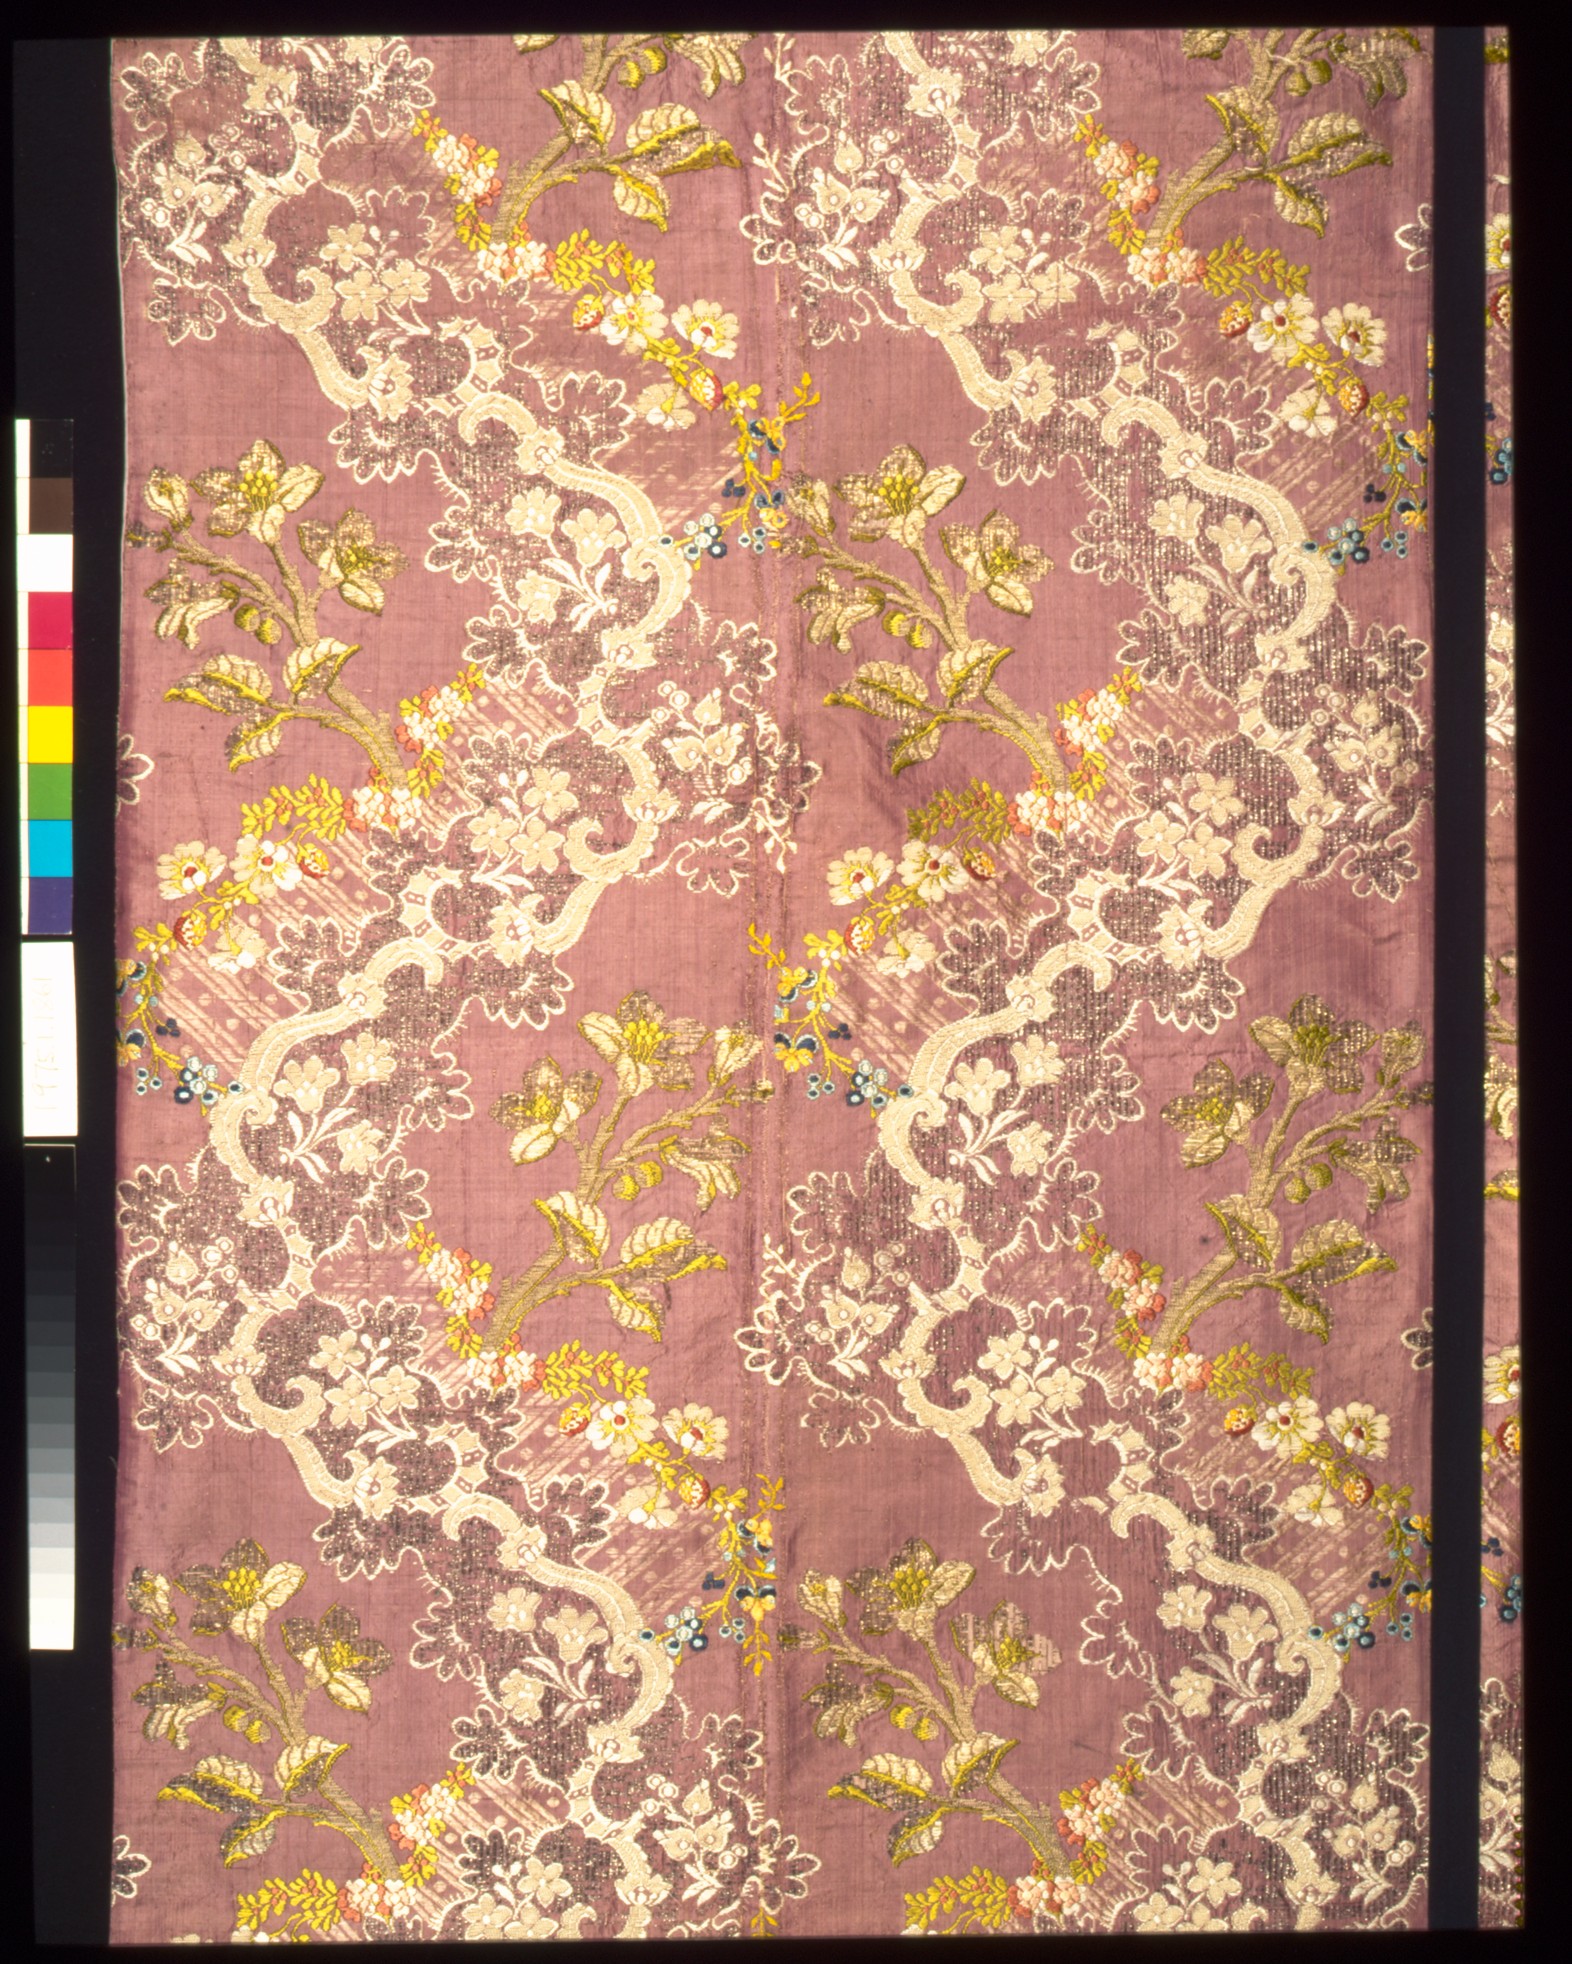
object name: textile panel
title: Panel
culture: french or italian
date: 1750-1770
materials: cotton, metal, silk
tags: flowers